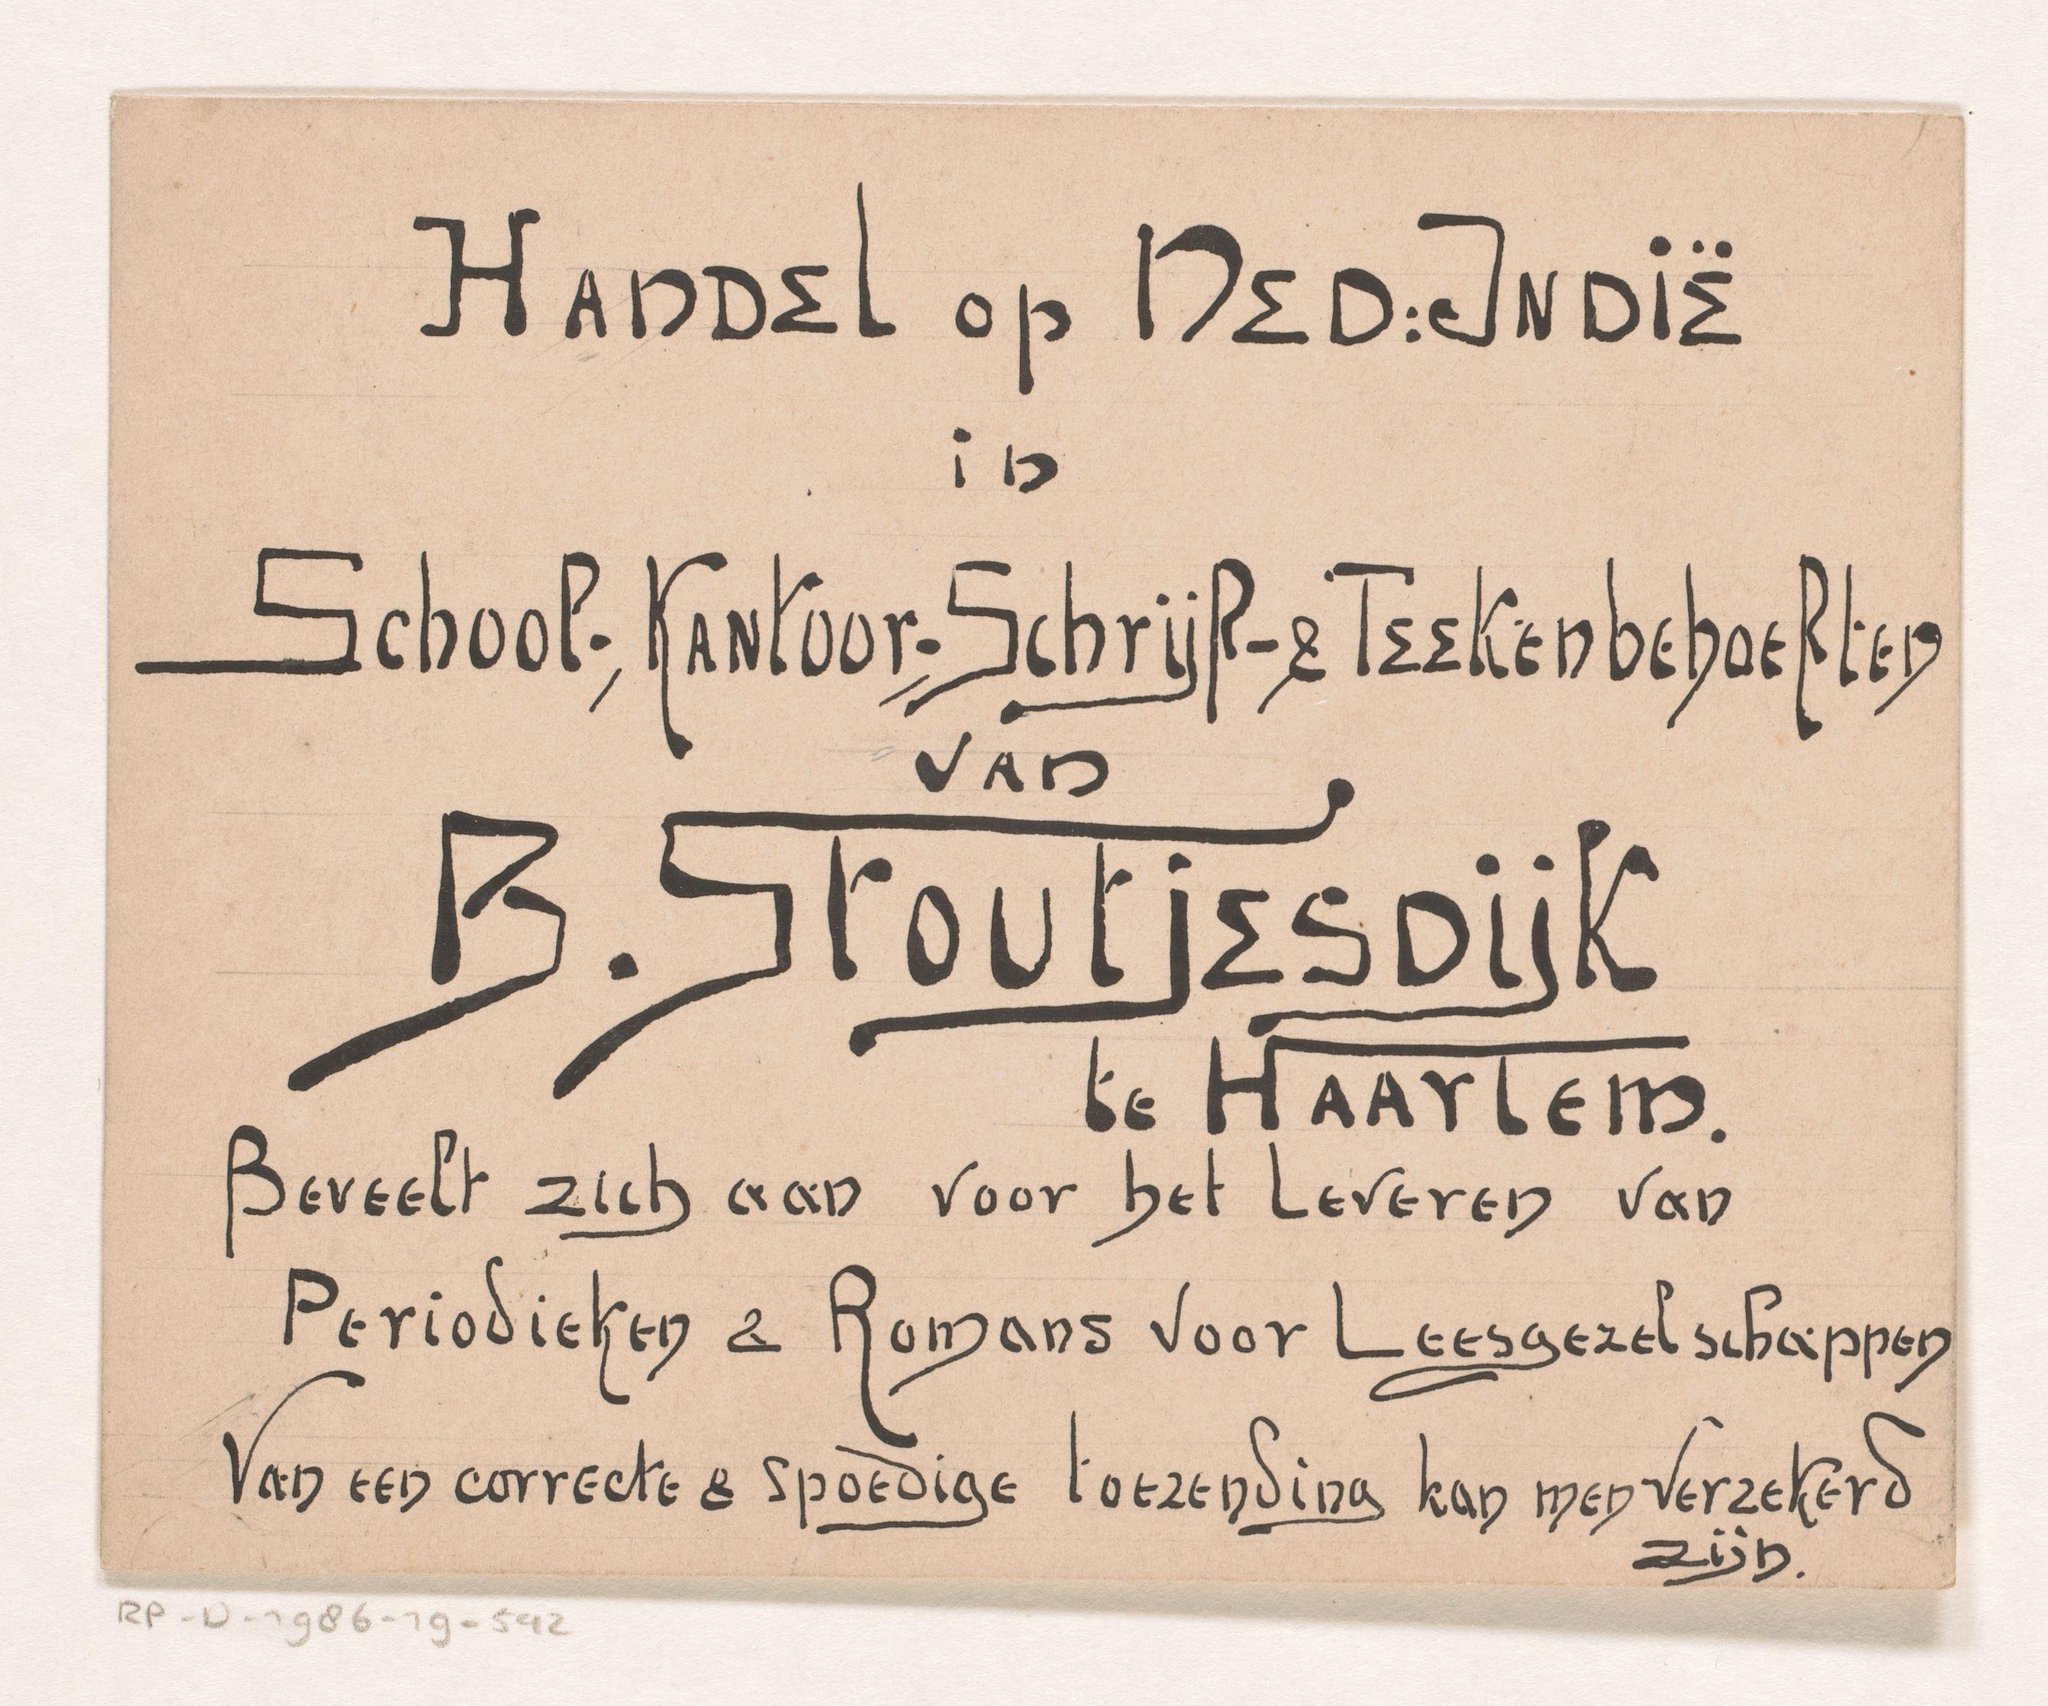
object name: design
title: Ontwerp voor een advertentie van B. Stoutjesdijk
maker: reinier willem petrus de vries (1874-1953)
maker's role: draughtsman, print maker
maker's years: 1874-1953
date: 1895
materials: ink, paper, pencil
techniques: pen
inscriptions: collector's mark: ‘R:MVS.’